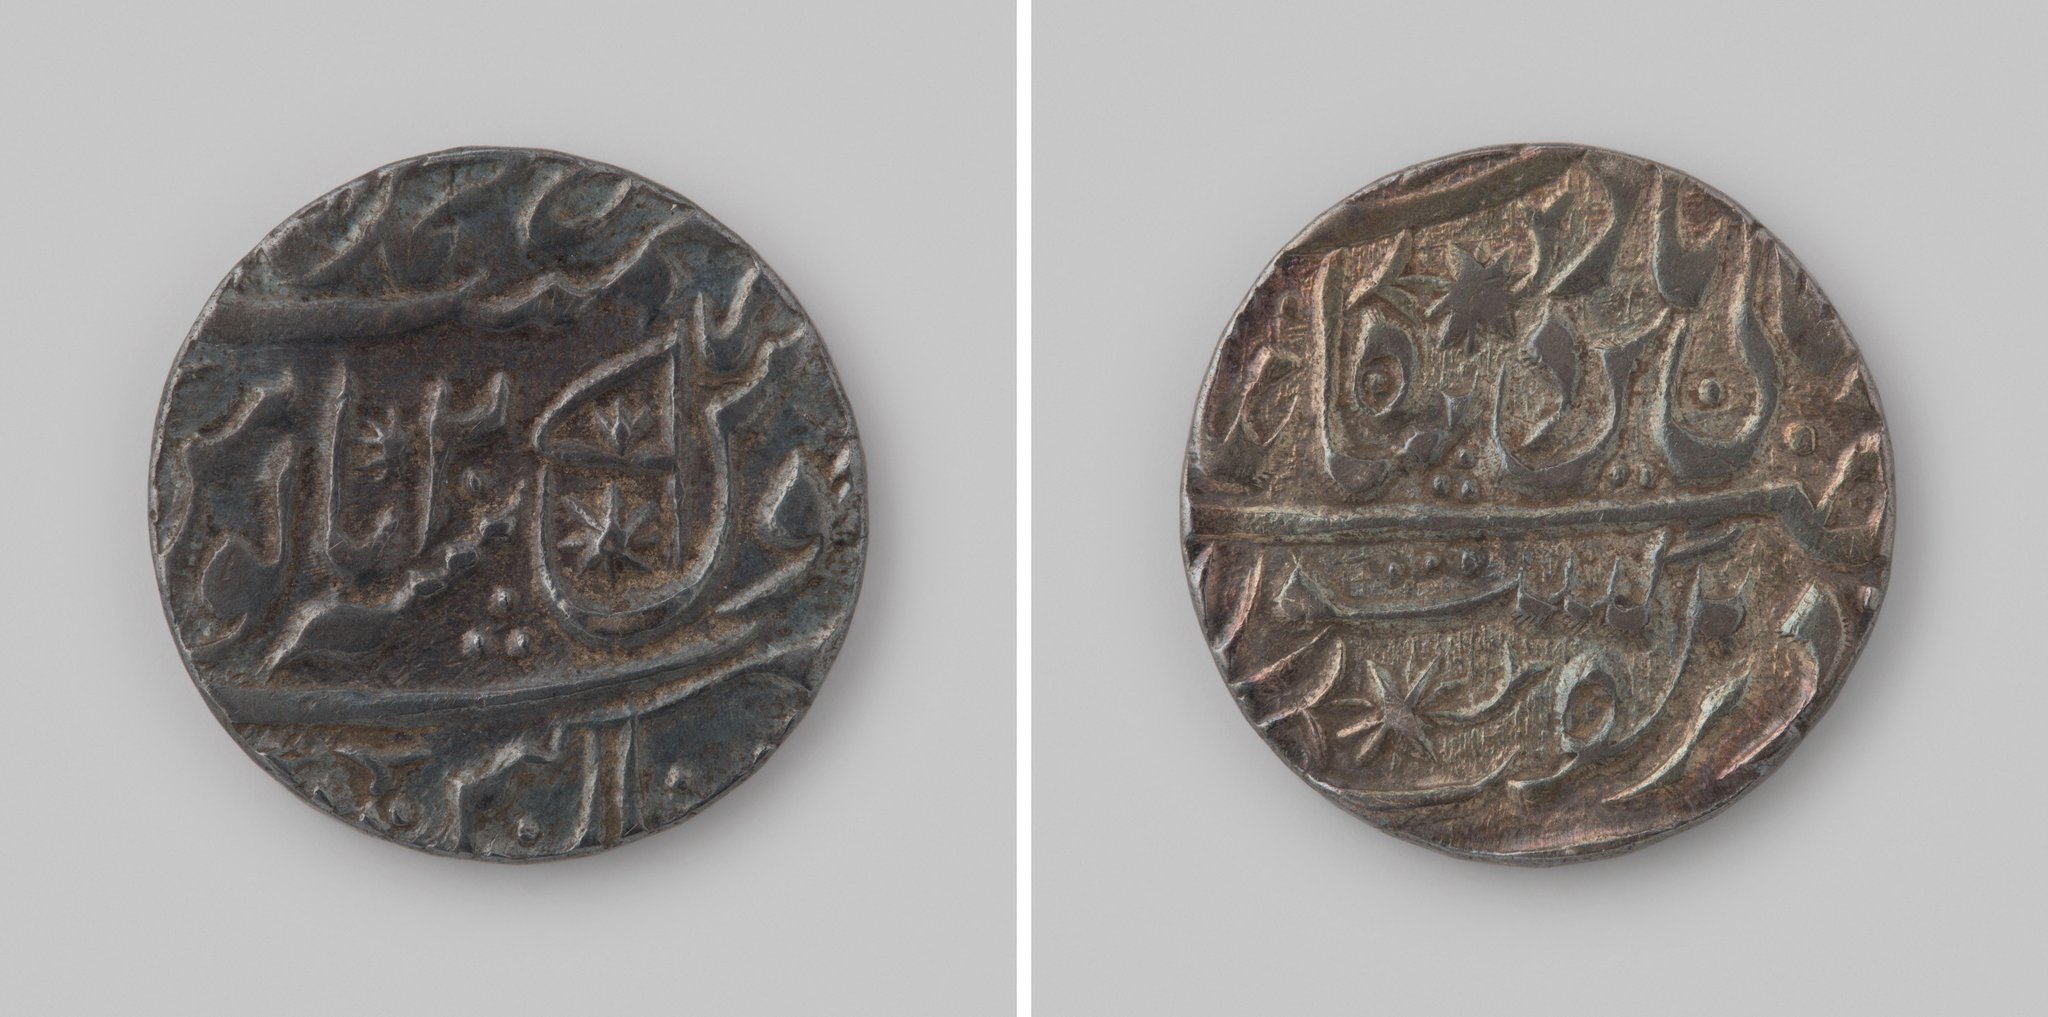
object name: coin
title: India, sjah Alam II, roepie, 1174 [=1760], geslagen te Banaras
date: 1760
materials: silver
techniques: striking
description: Zilveren munt. Voorzijde: in Arabische lettertekens in drie regels opschrift. Keerzijde: in Arabische lettertekens in vier regels opschrift met aanduiding regeringsjaar 2 [=1174] en aanduiding muntplaats: Banaras.